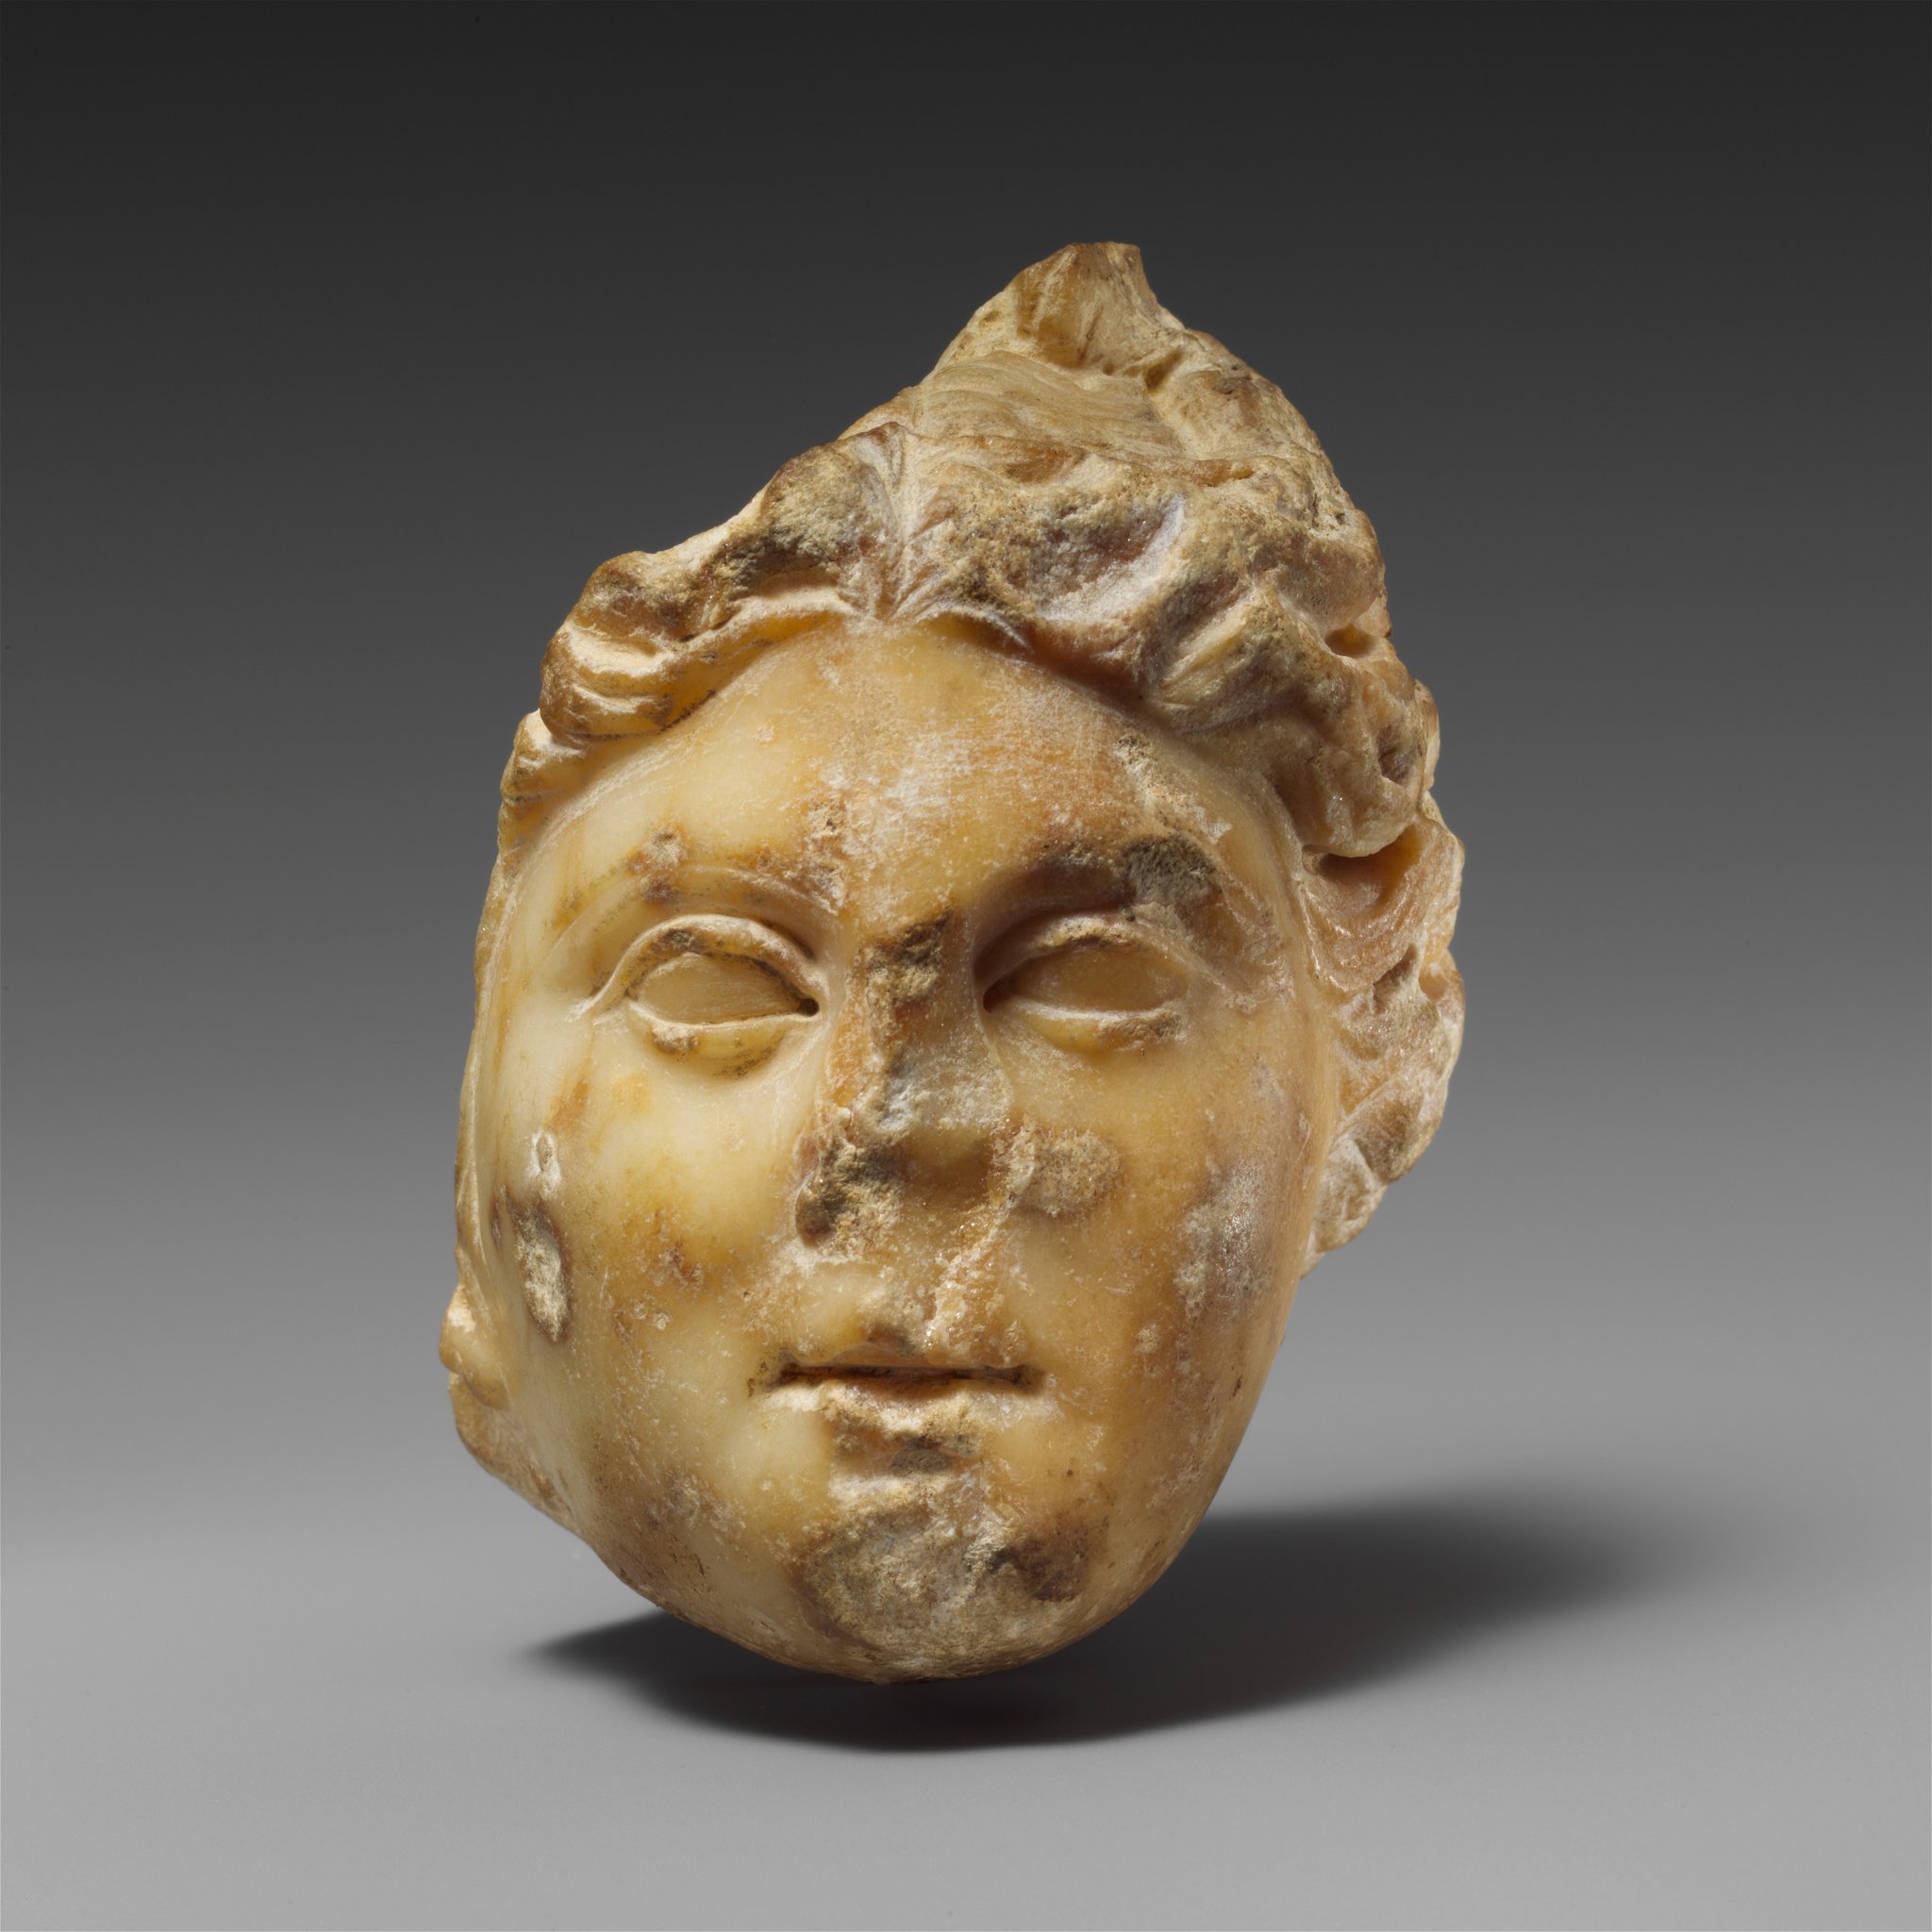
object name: head of a woman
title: Marble female relief head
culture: roman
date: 1-200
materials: marble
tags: heads,women